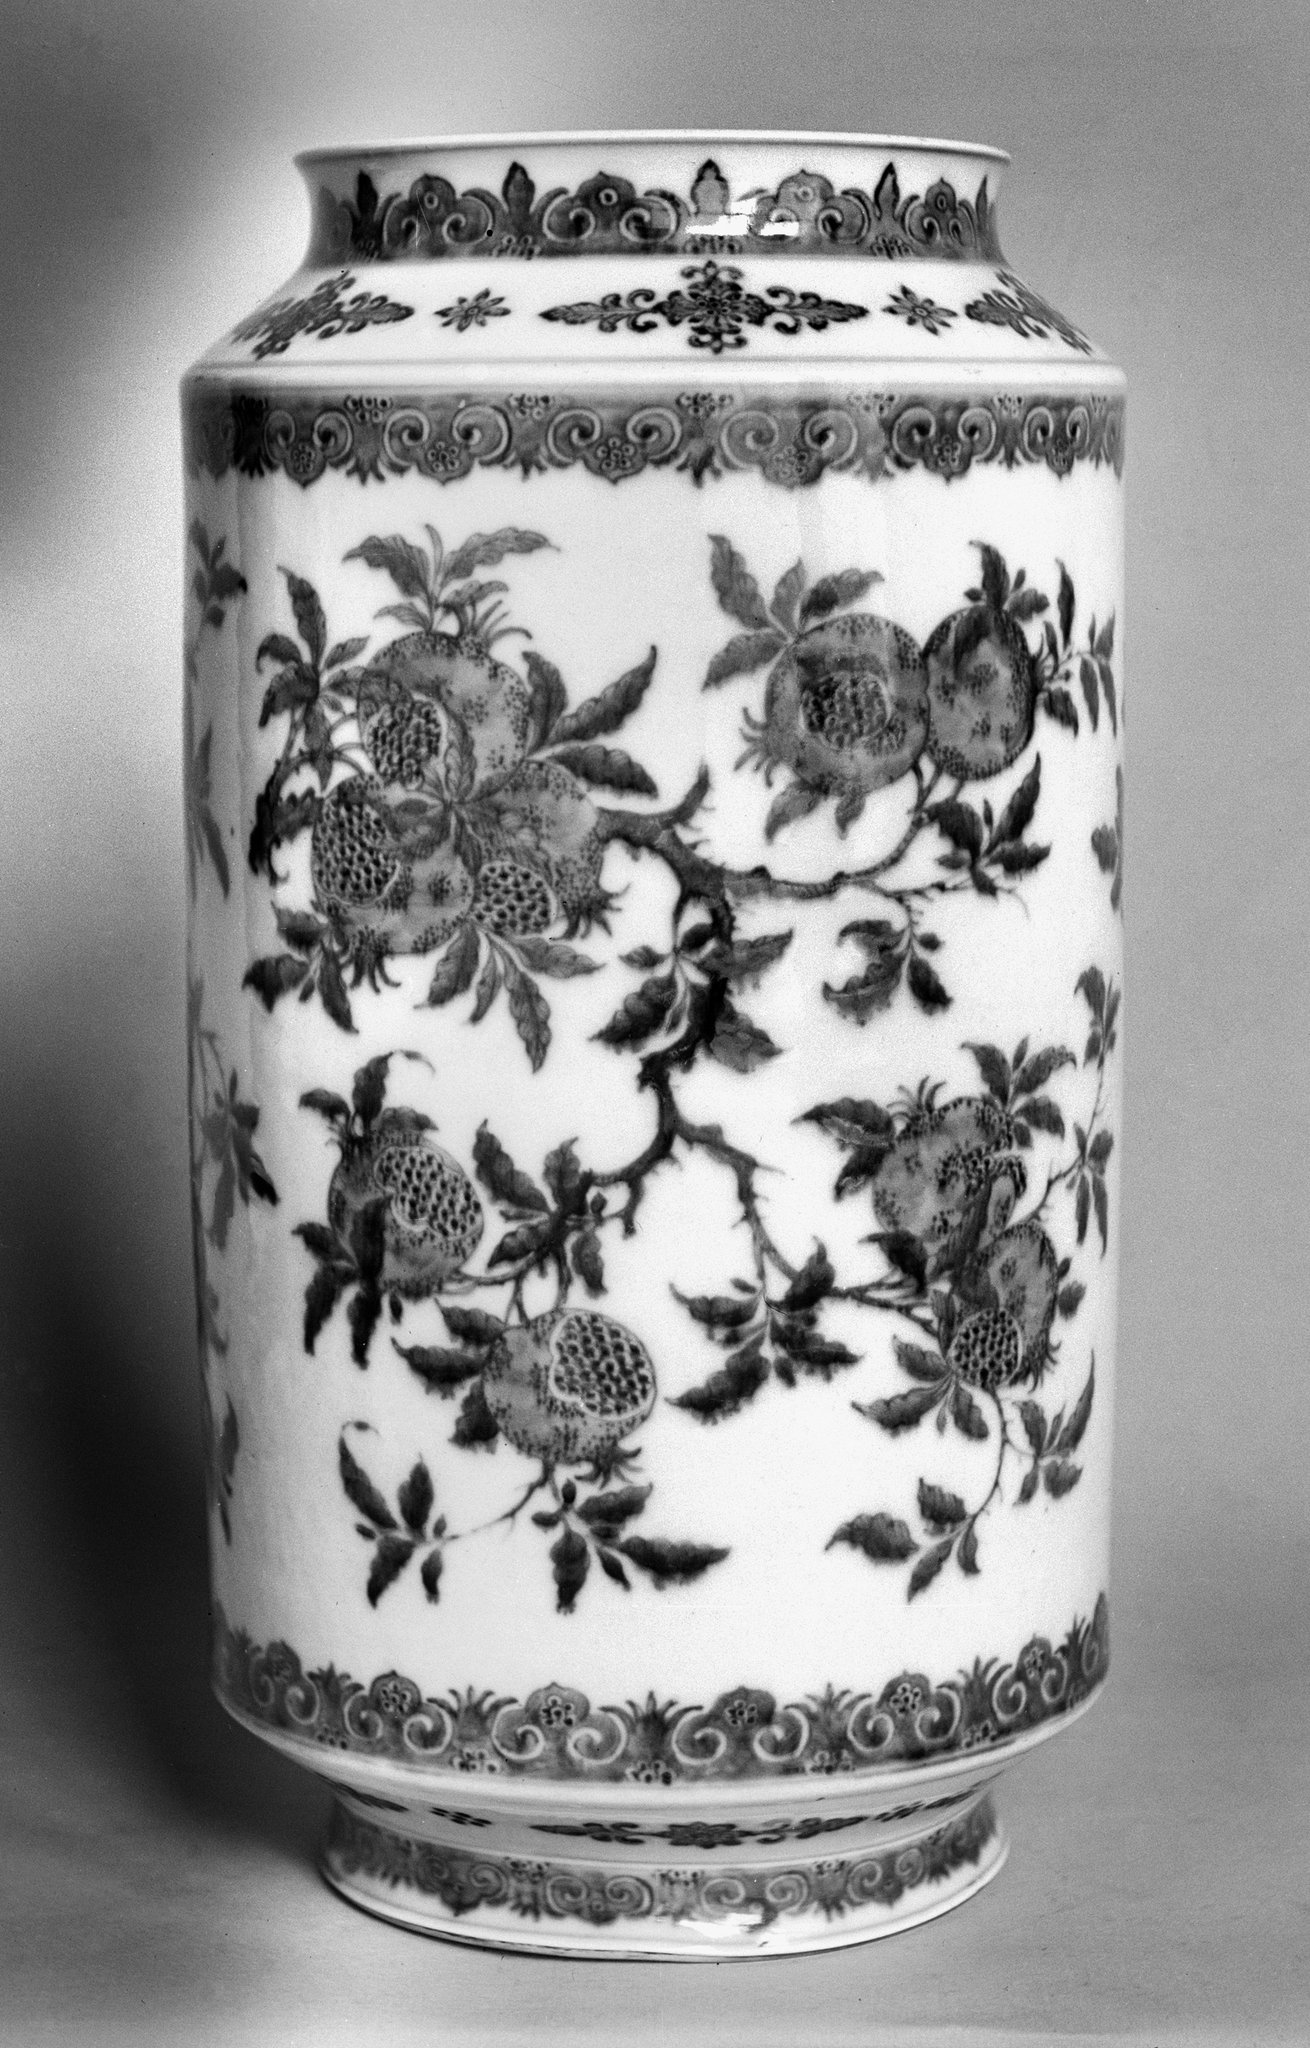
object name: vase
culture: chinese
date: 1736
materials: porcelain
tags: fruit,leaves